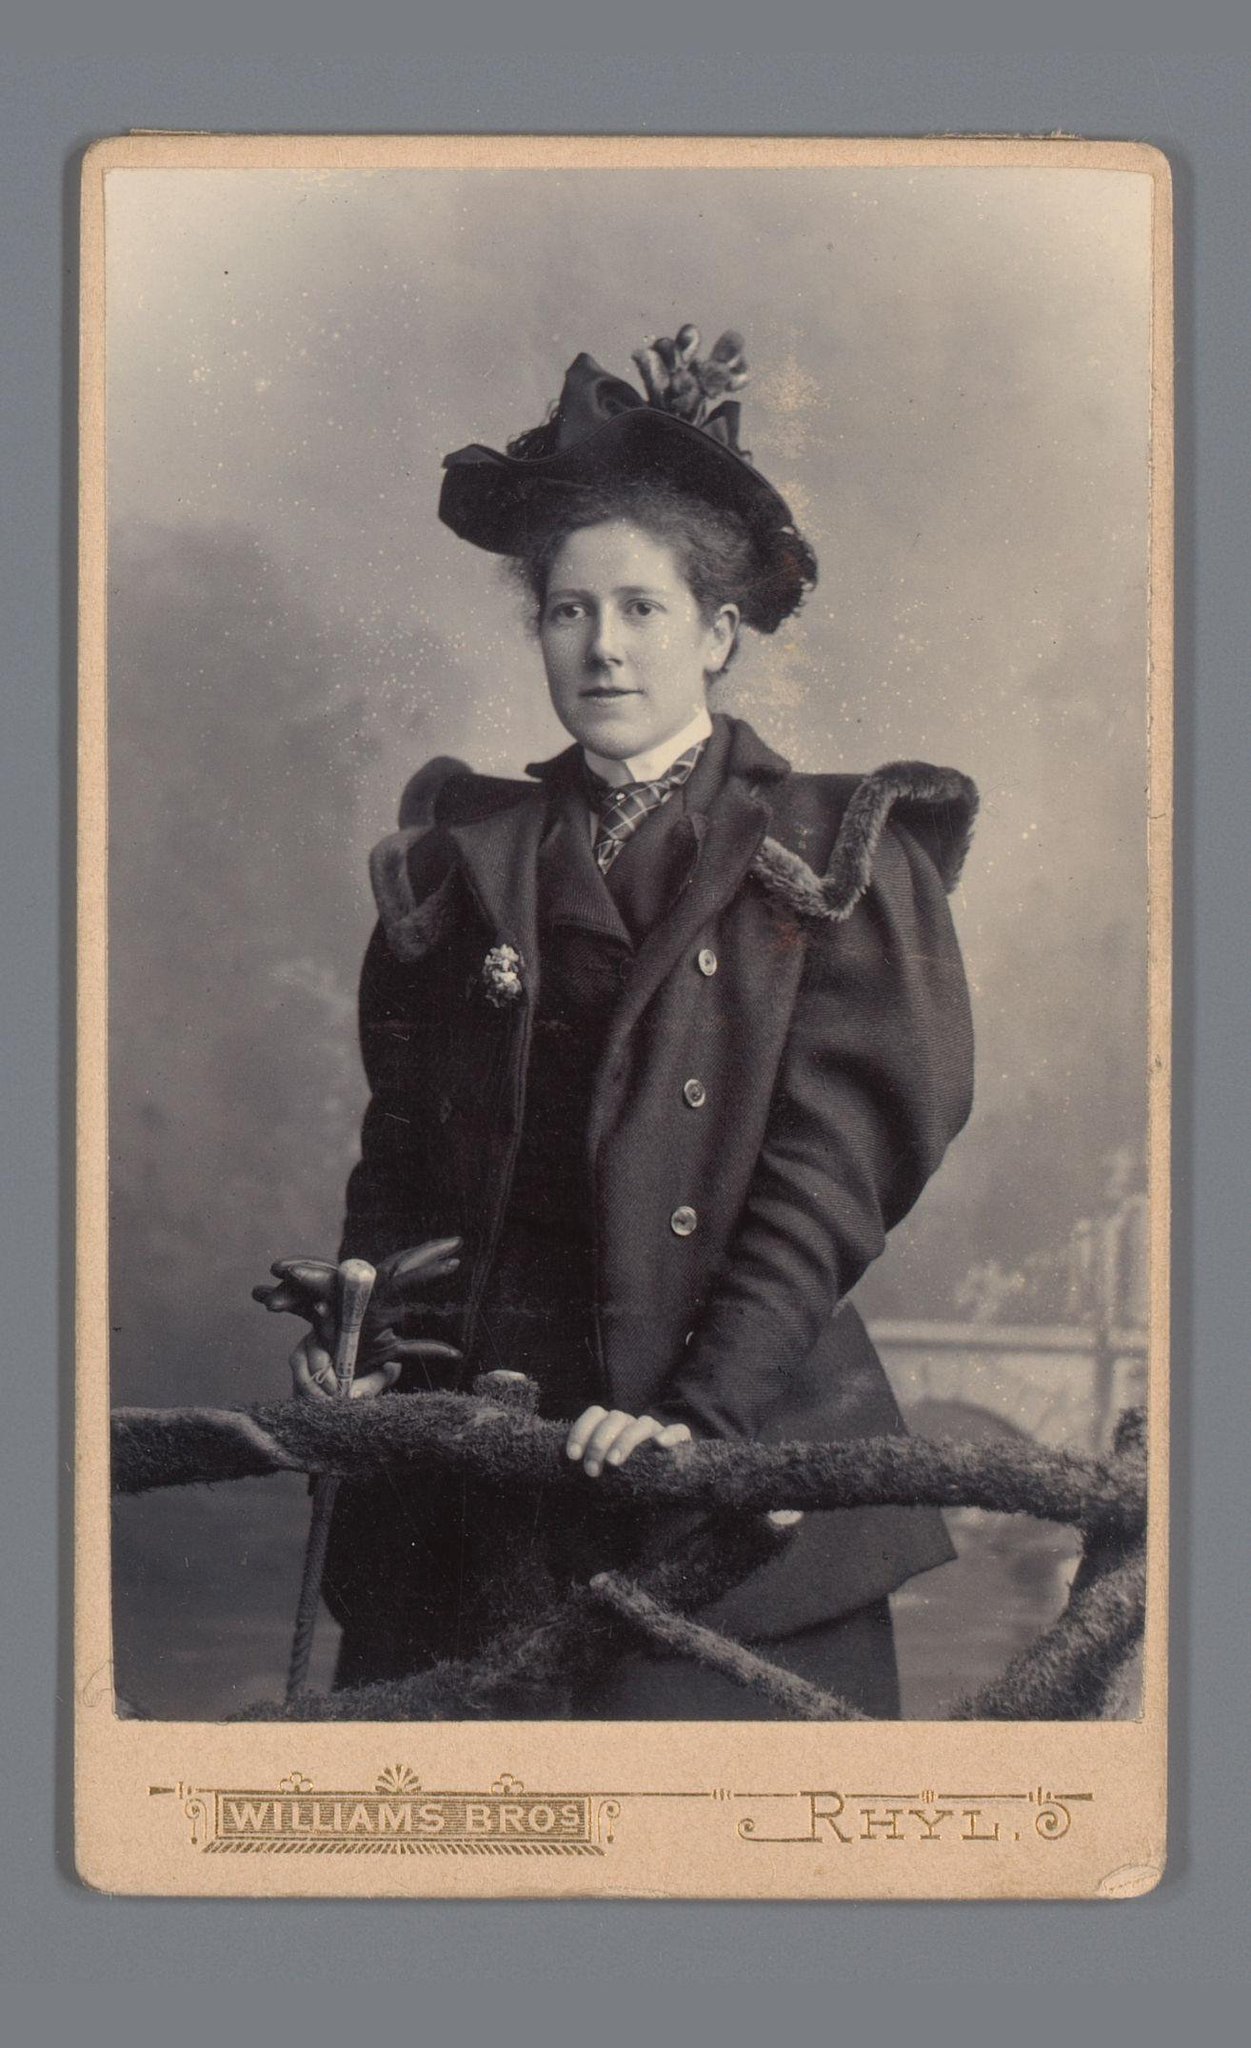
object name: photograph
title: Portret van een onbekende vrouw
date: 1900-1914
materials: paper, cardboard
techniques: gelatin silver print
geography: rhyl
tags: adult woman, anonymous historical person portrayed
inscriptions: inscription: ‘HIGHLY FINISHED ENLARGEMENTS MAY BE OBAINED/ FROM HIS PHOTOGRAPH./ ALEX : LINDNER-BERLIN.’, address: ‘23 High Street. RHYL’